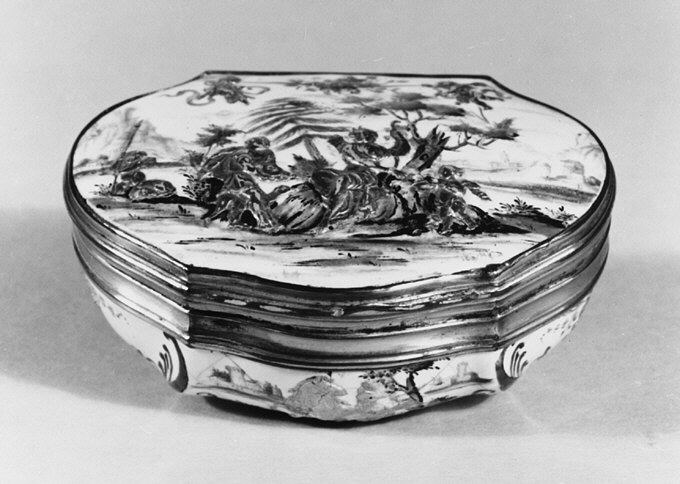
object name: snuffbox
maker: workshop of charles fromery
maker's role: maker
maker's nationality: german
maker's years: 1685-1738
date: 1740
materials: copper, enamel, gilt, gold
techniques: painting